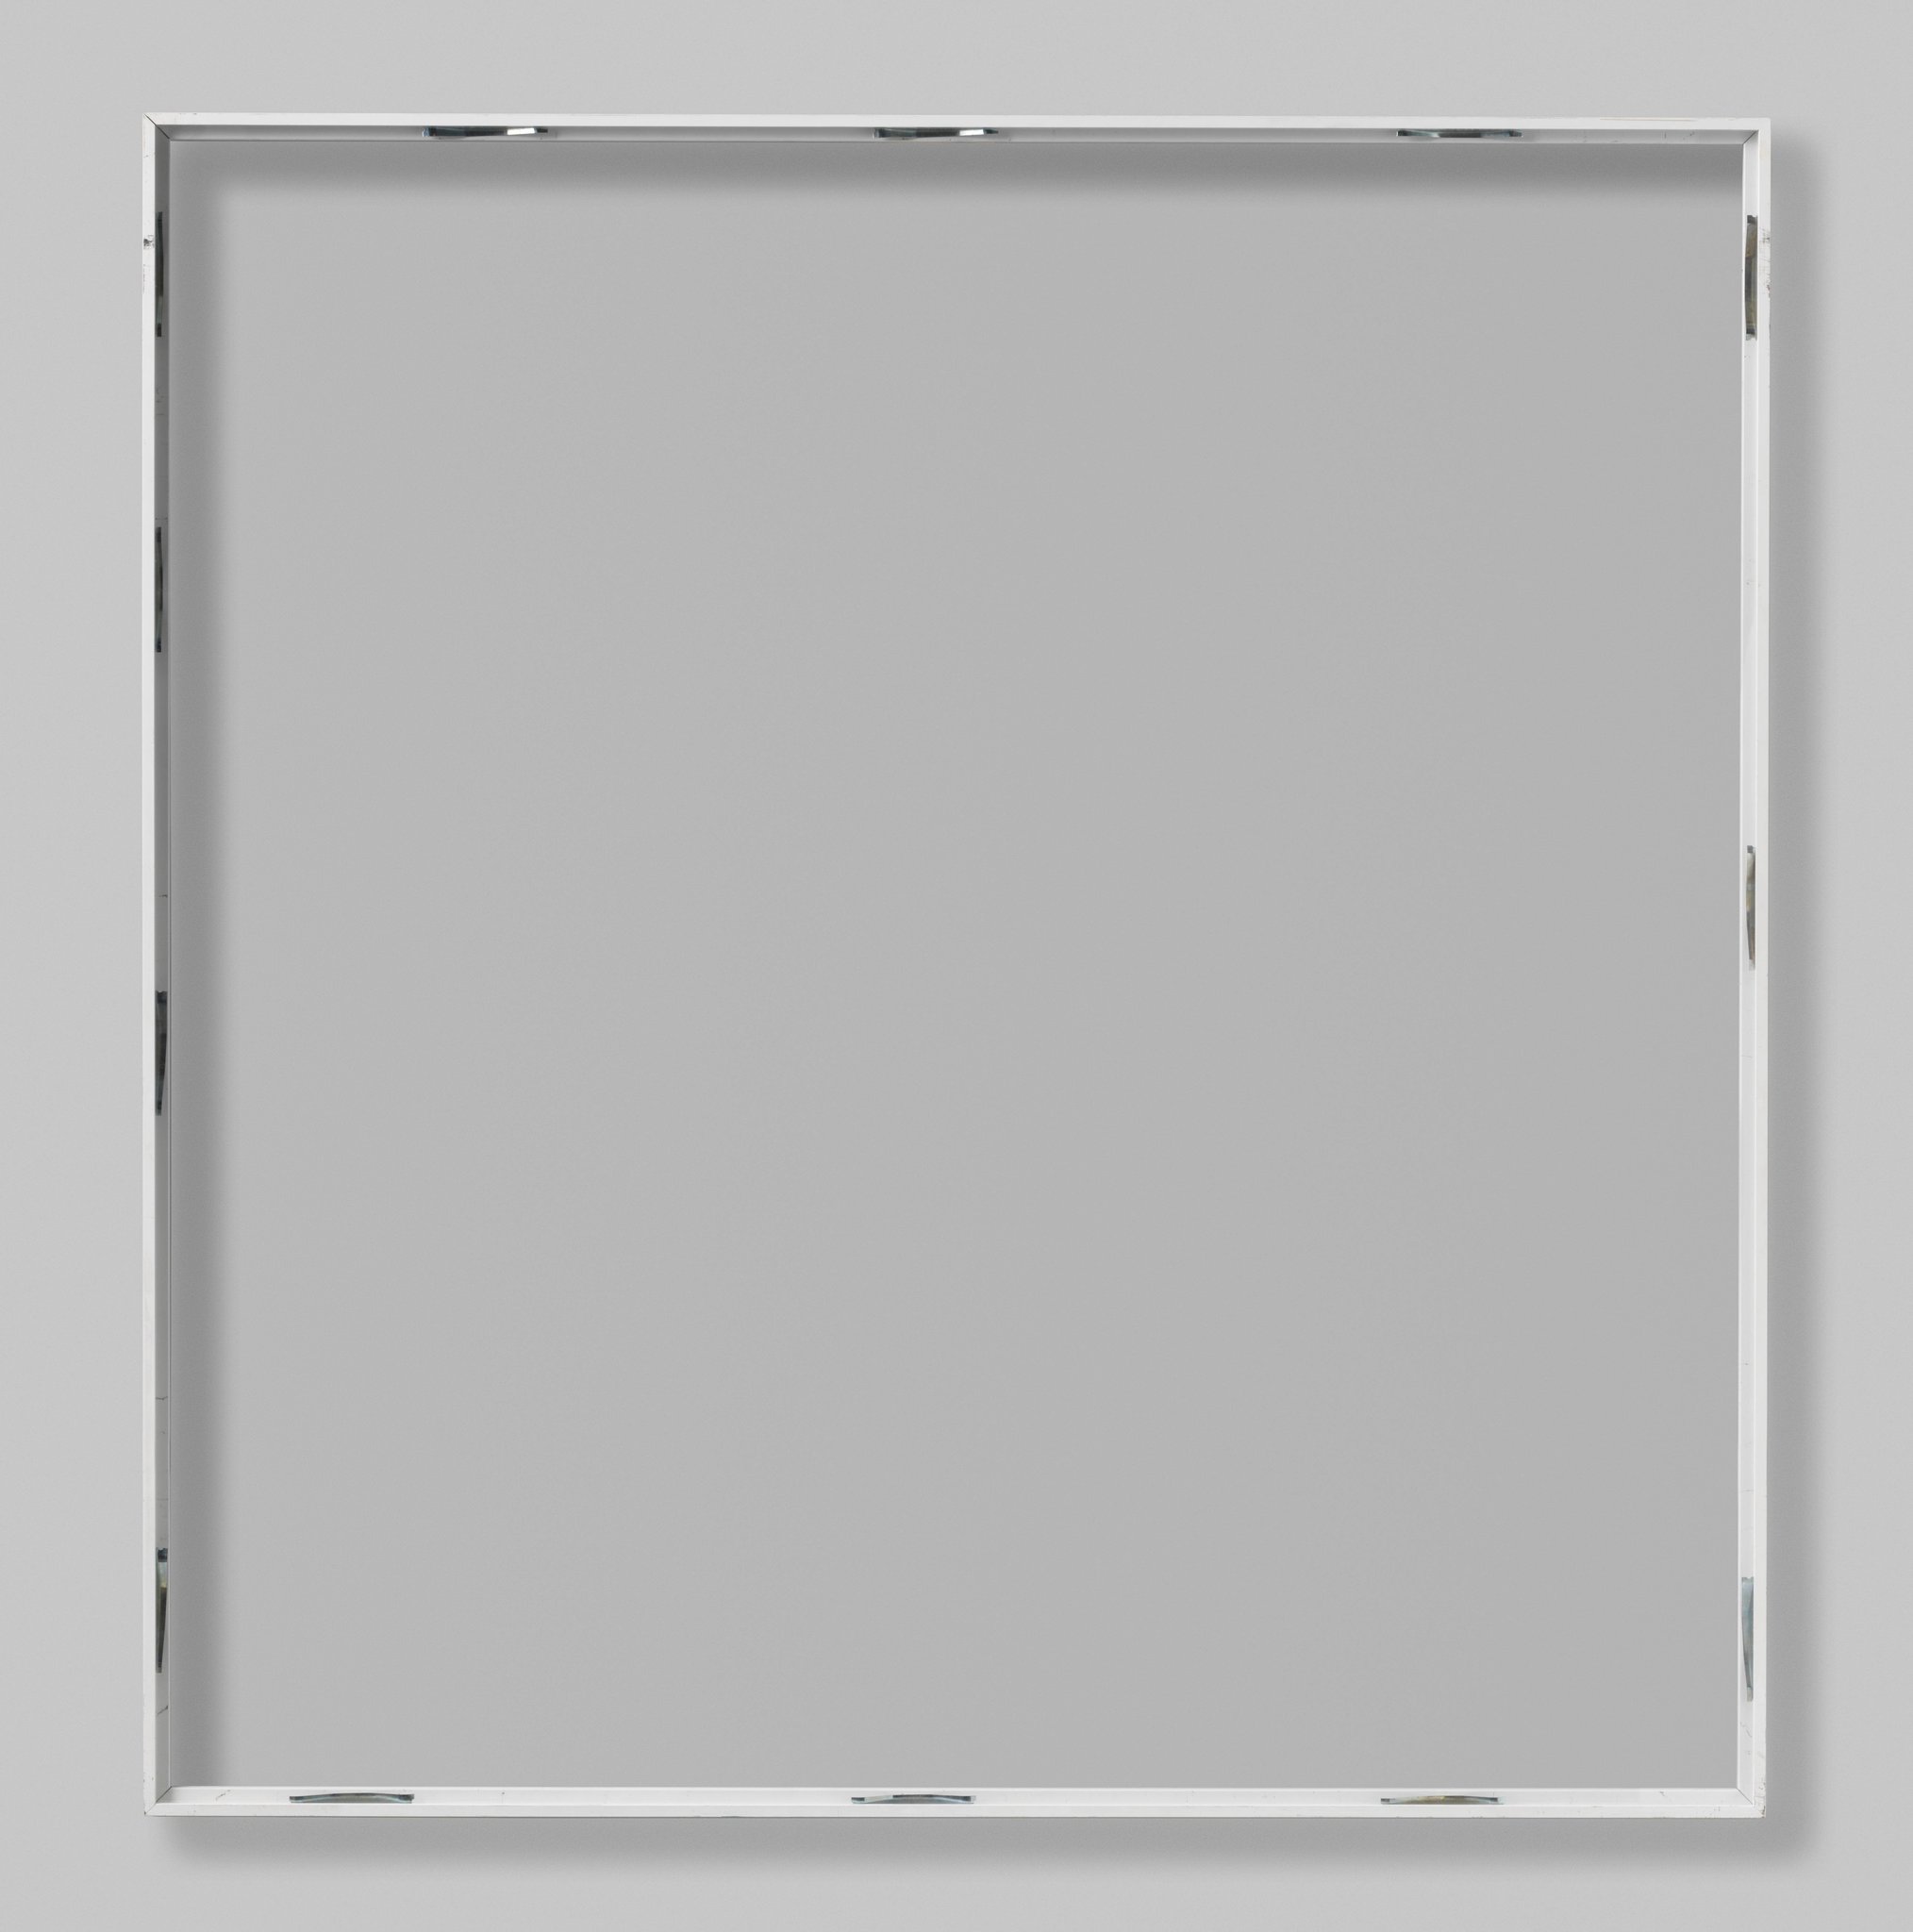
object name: frame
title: Smalle wit gecoate metalen lijst.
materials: metal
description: Metalen witgeverfde versteklijst met plexiglas voorplaat.